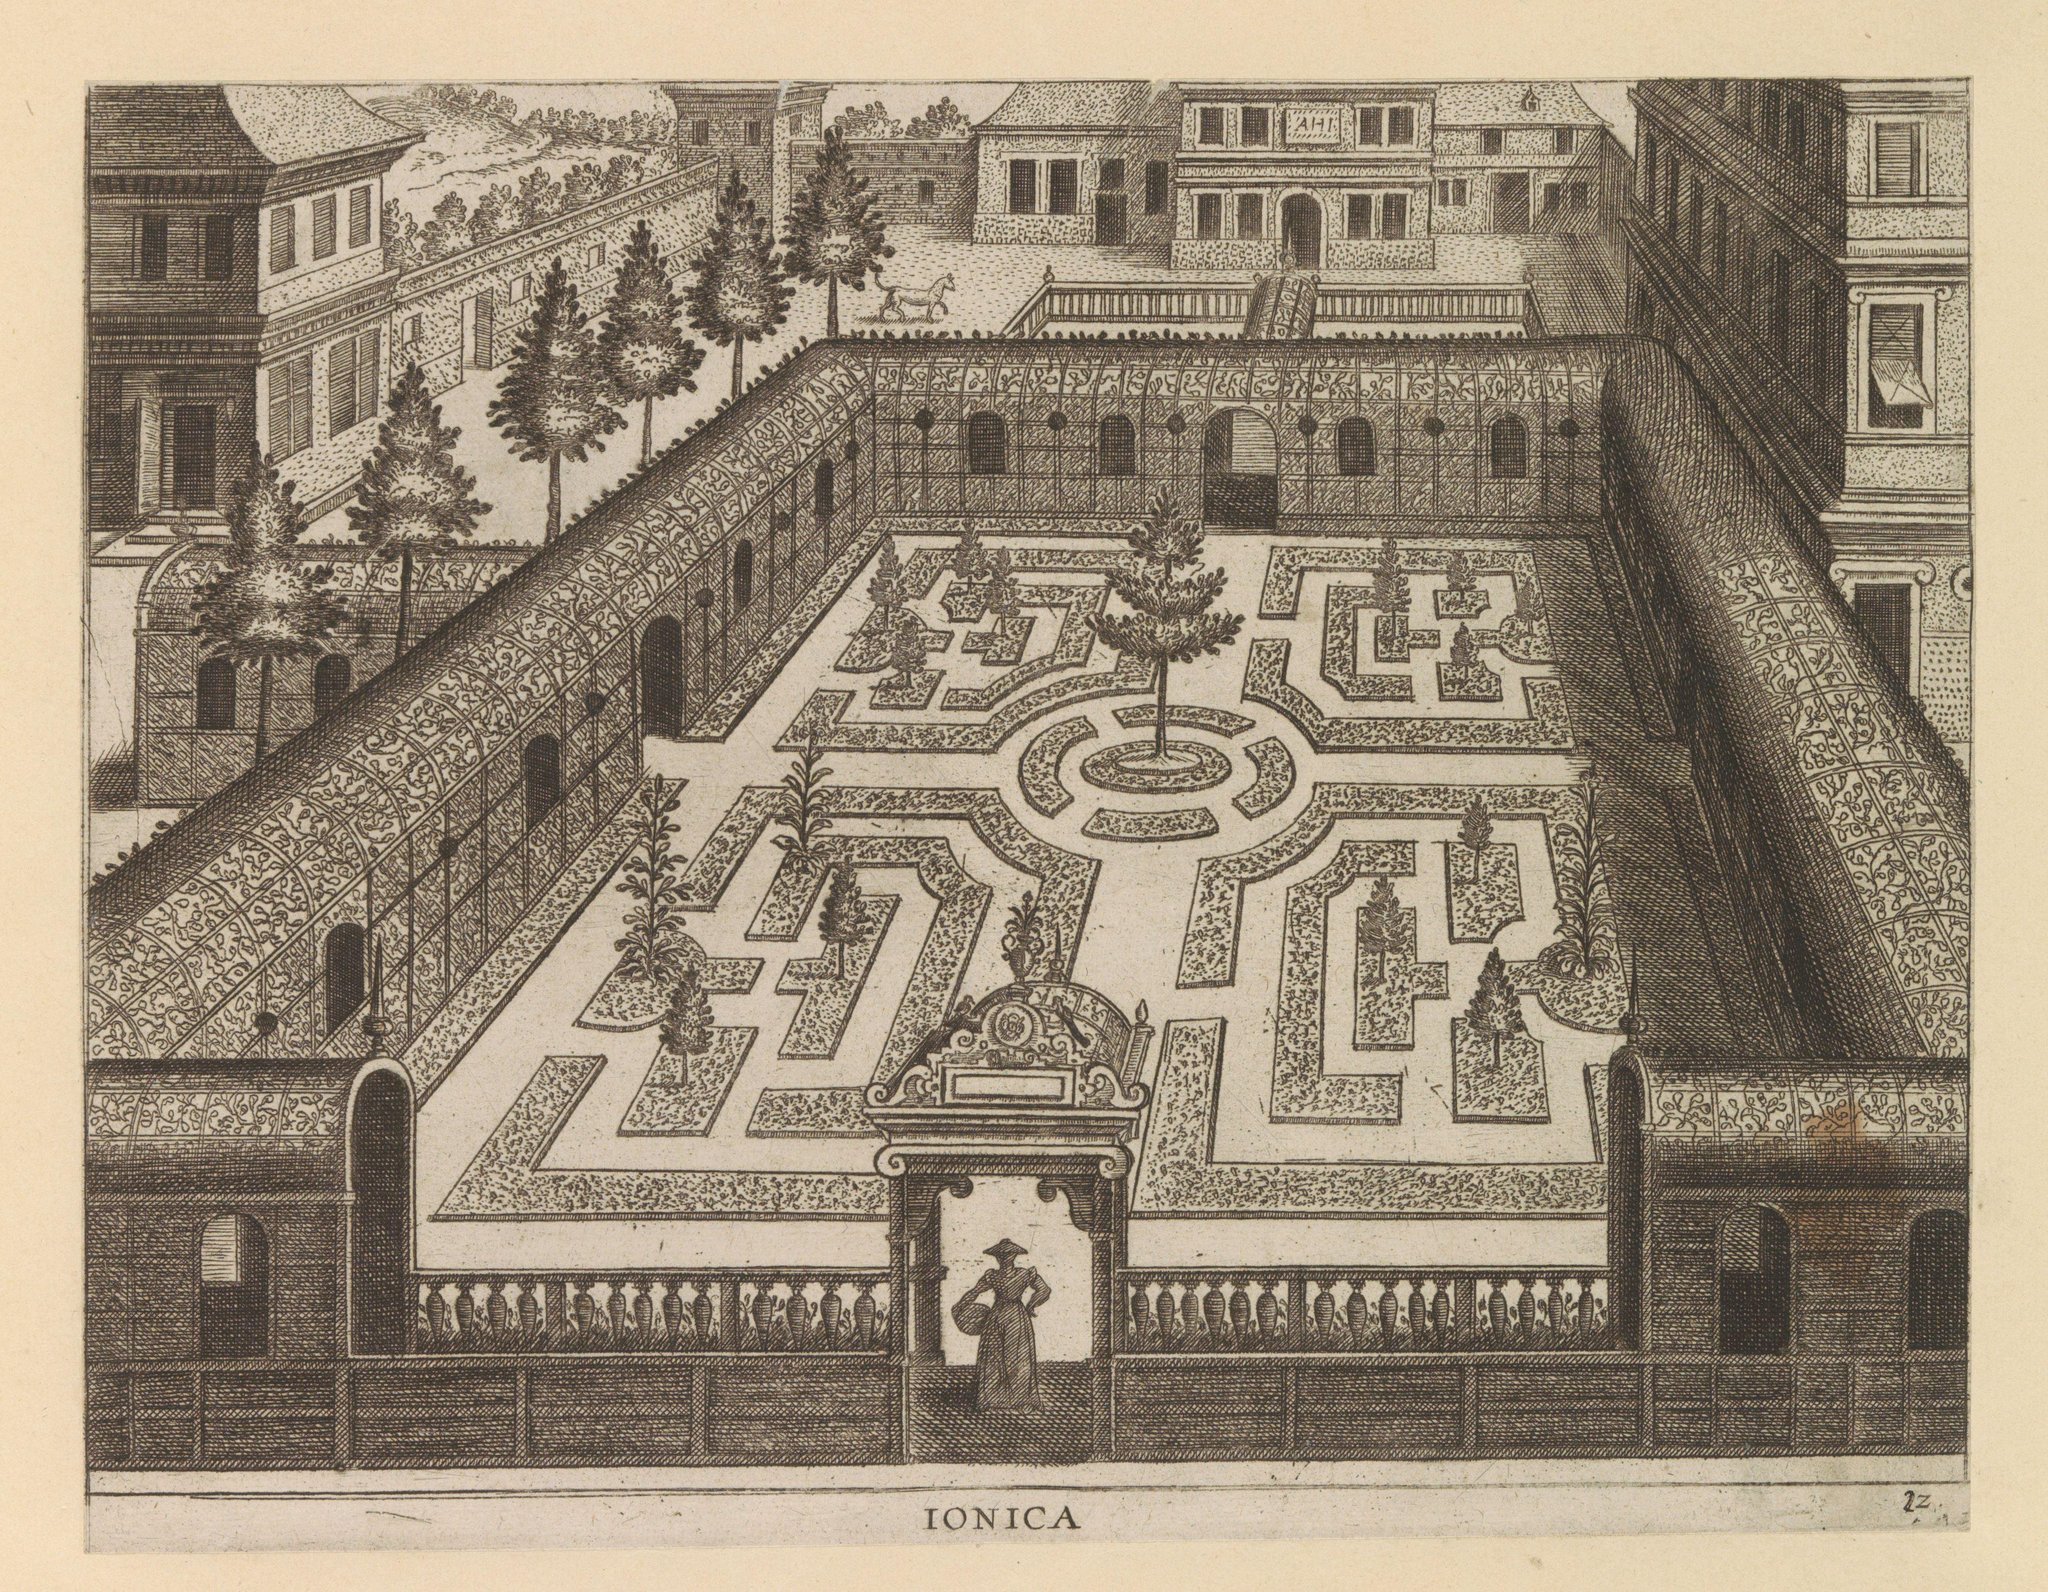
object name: print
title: Ionica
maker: Anonymous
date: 1583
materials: paper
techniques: etching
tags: garden, french or architectonic garden; formal garden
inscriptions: inscription: ‘2’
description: Tuin met een parterre omsloten door een begroeide gang van traliewerk. Op de voorgrond in het midden staat een vrouw in de poort. De tuin is aangelegd volgens de Ionische bouworde. De prent maakt deel uit van een album.